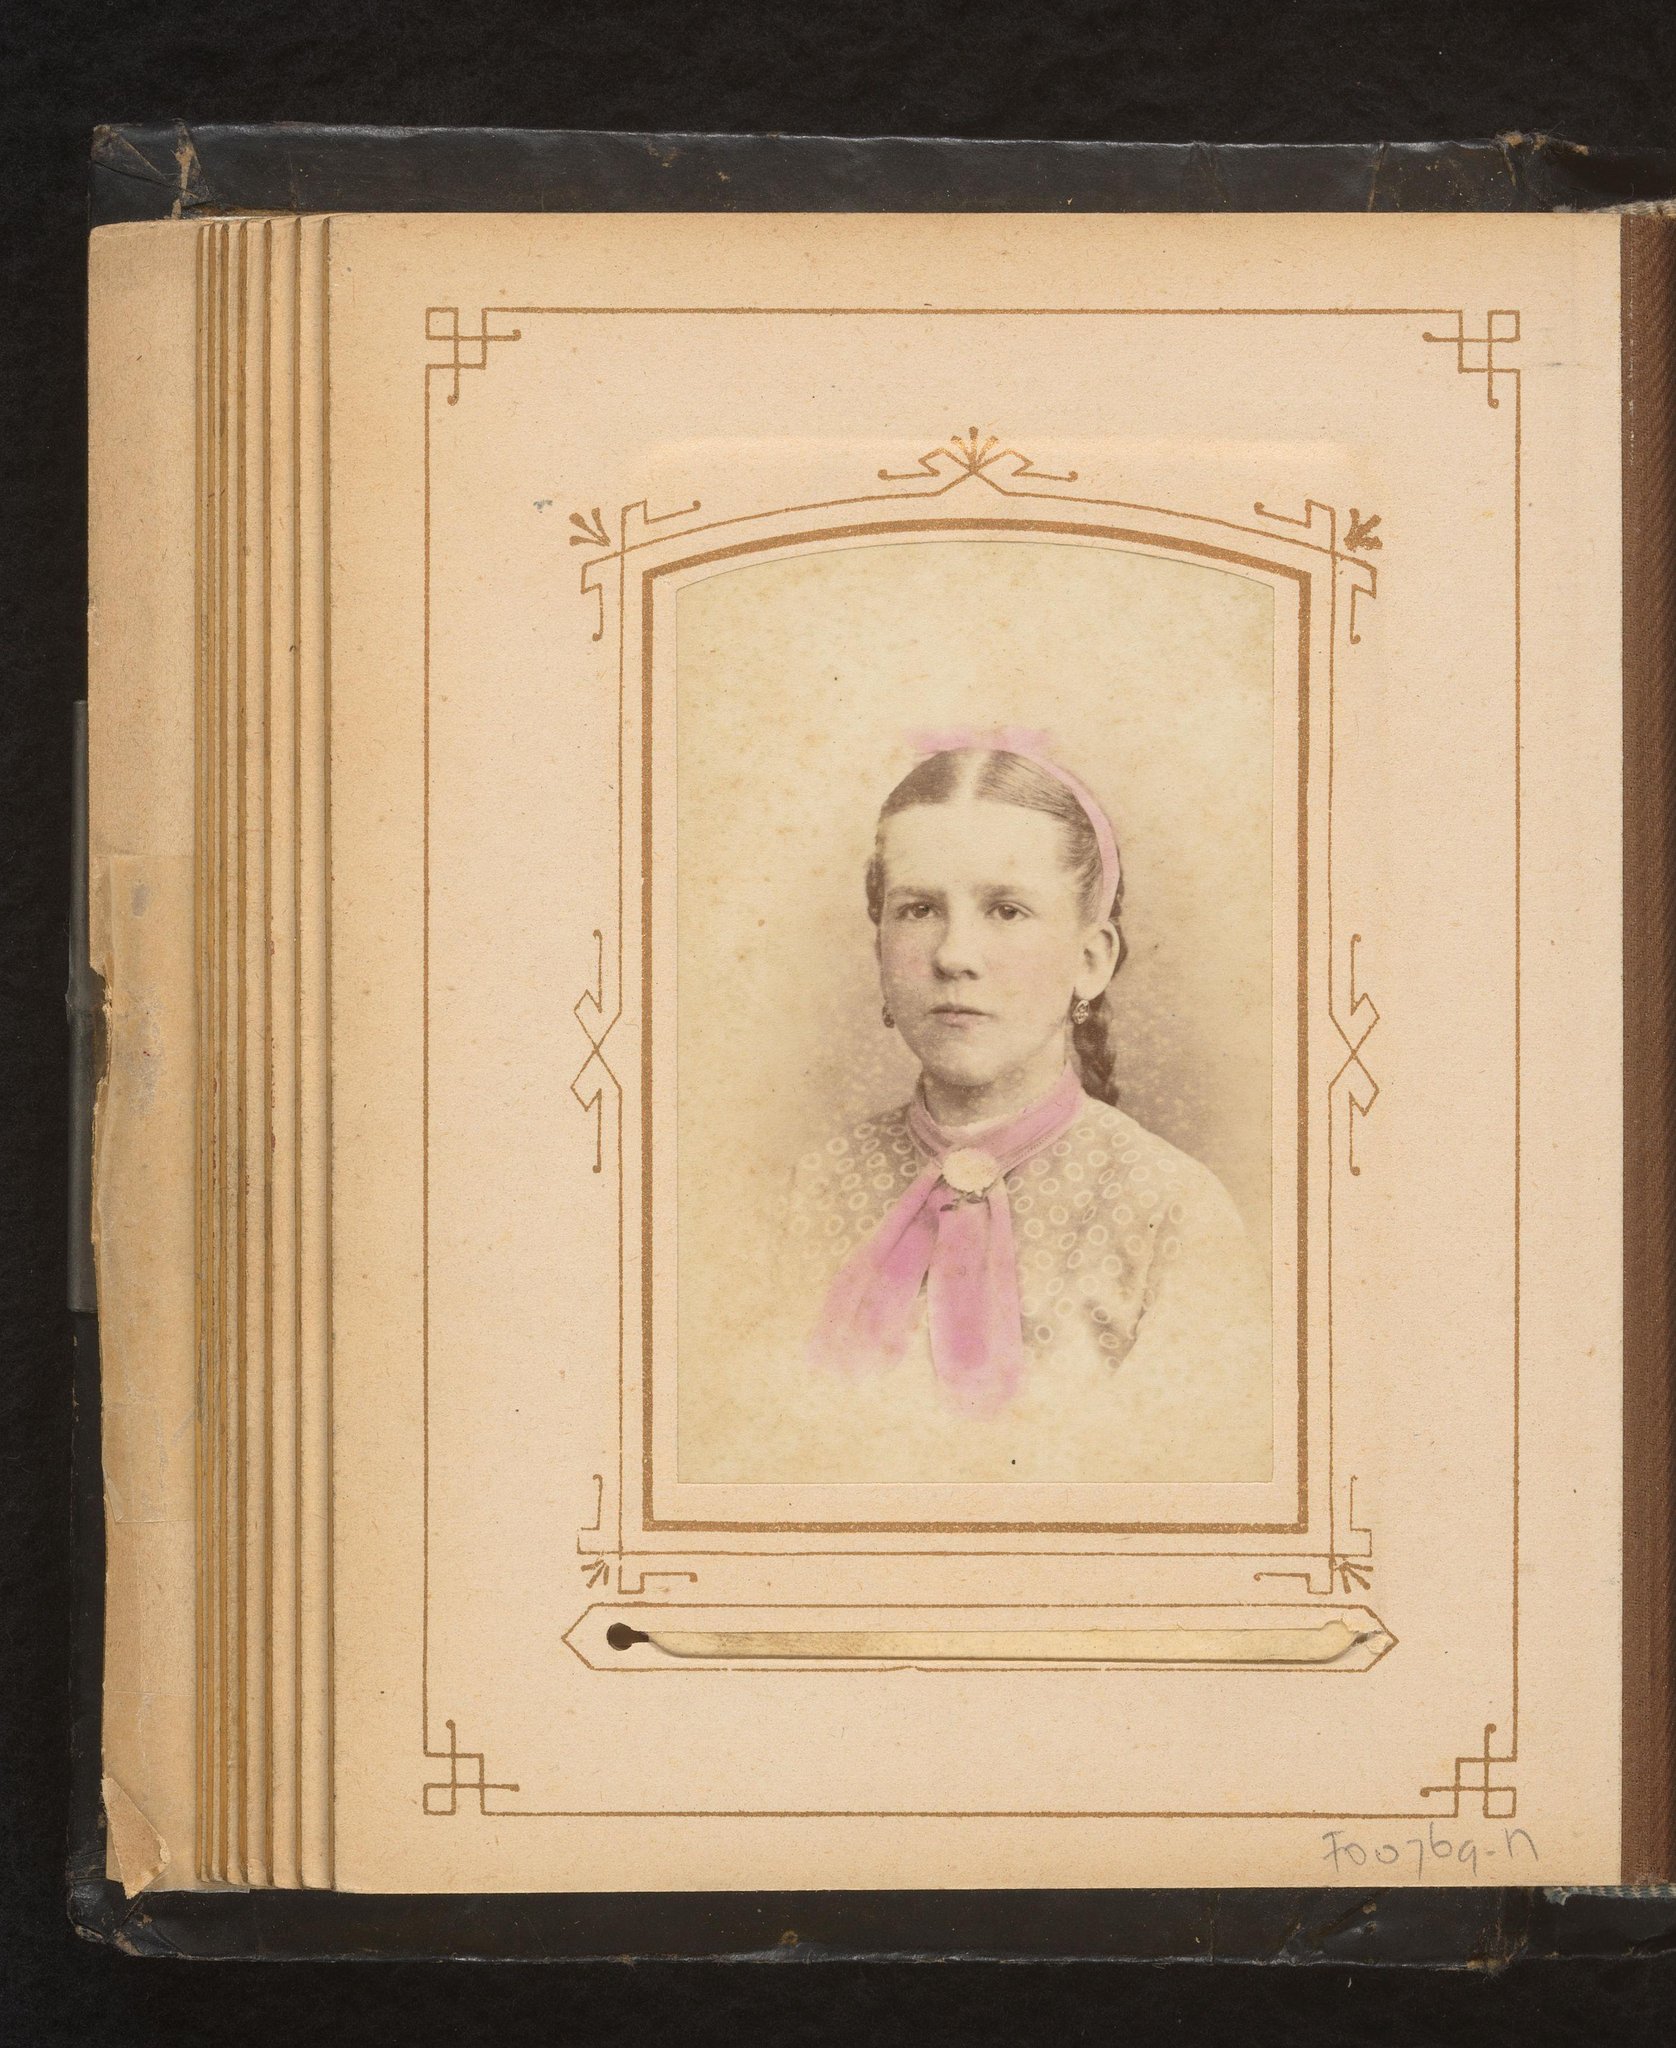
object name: album leaf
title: Portret van een meisje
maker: r. hoads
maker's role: fotograaf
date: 1870-1900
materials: cardboard, photographic support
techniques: albumen print, hand coloring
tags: historical persons, girl (child between toddler and youth)